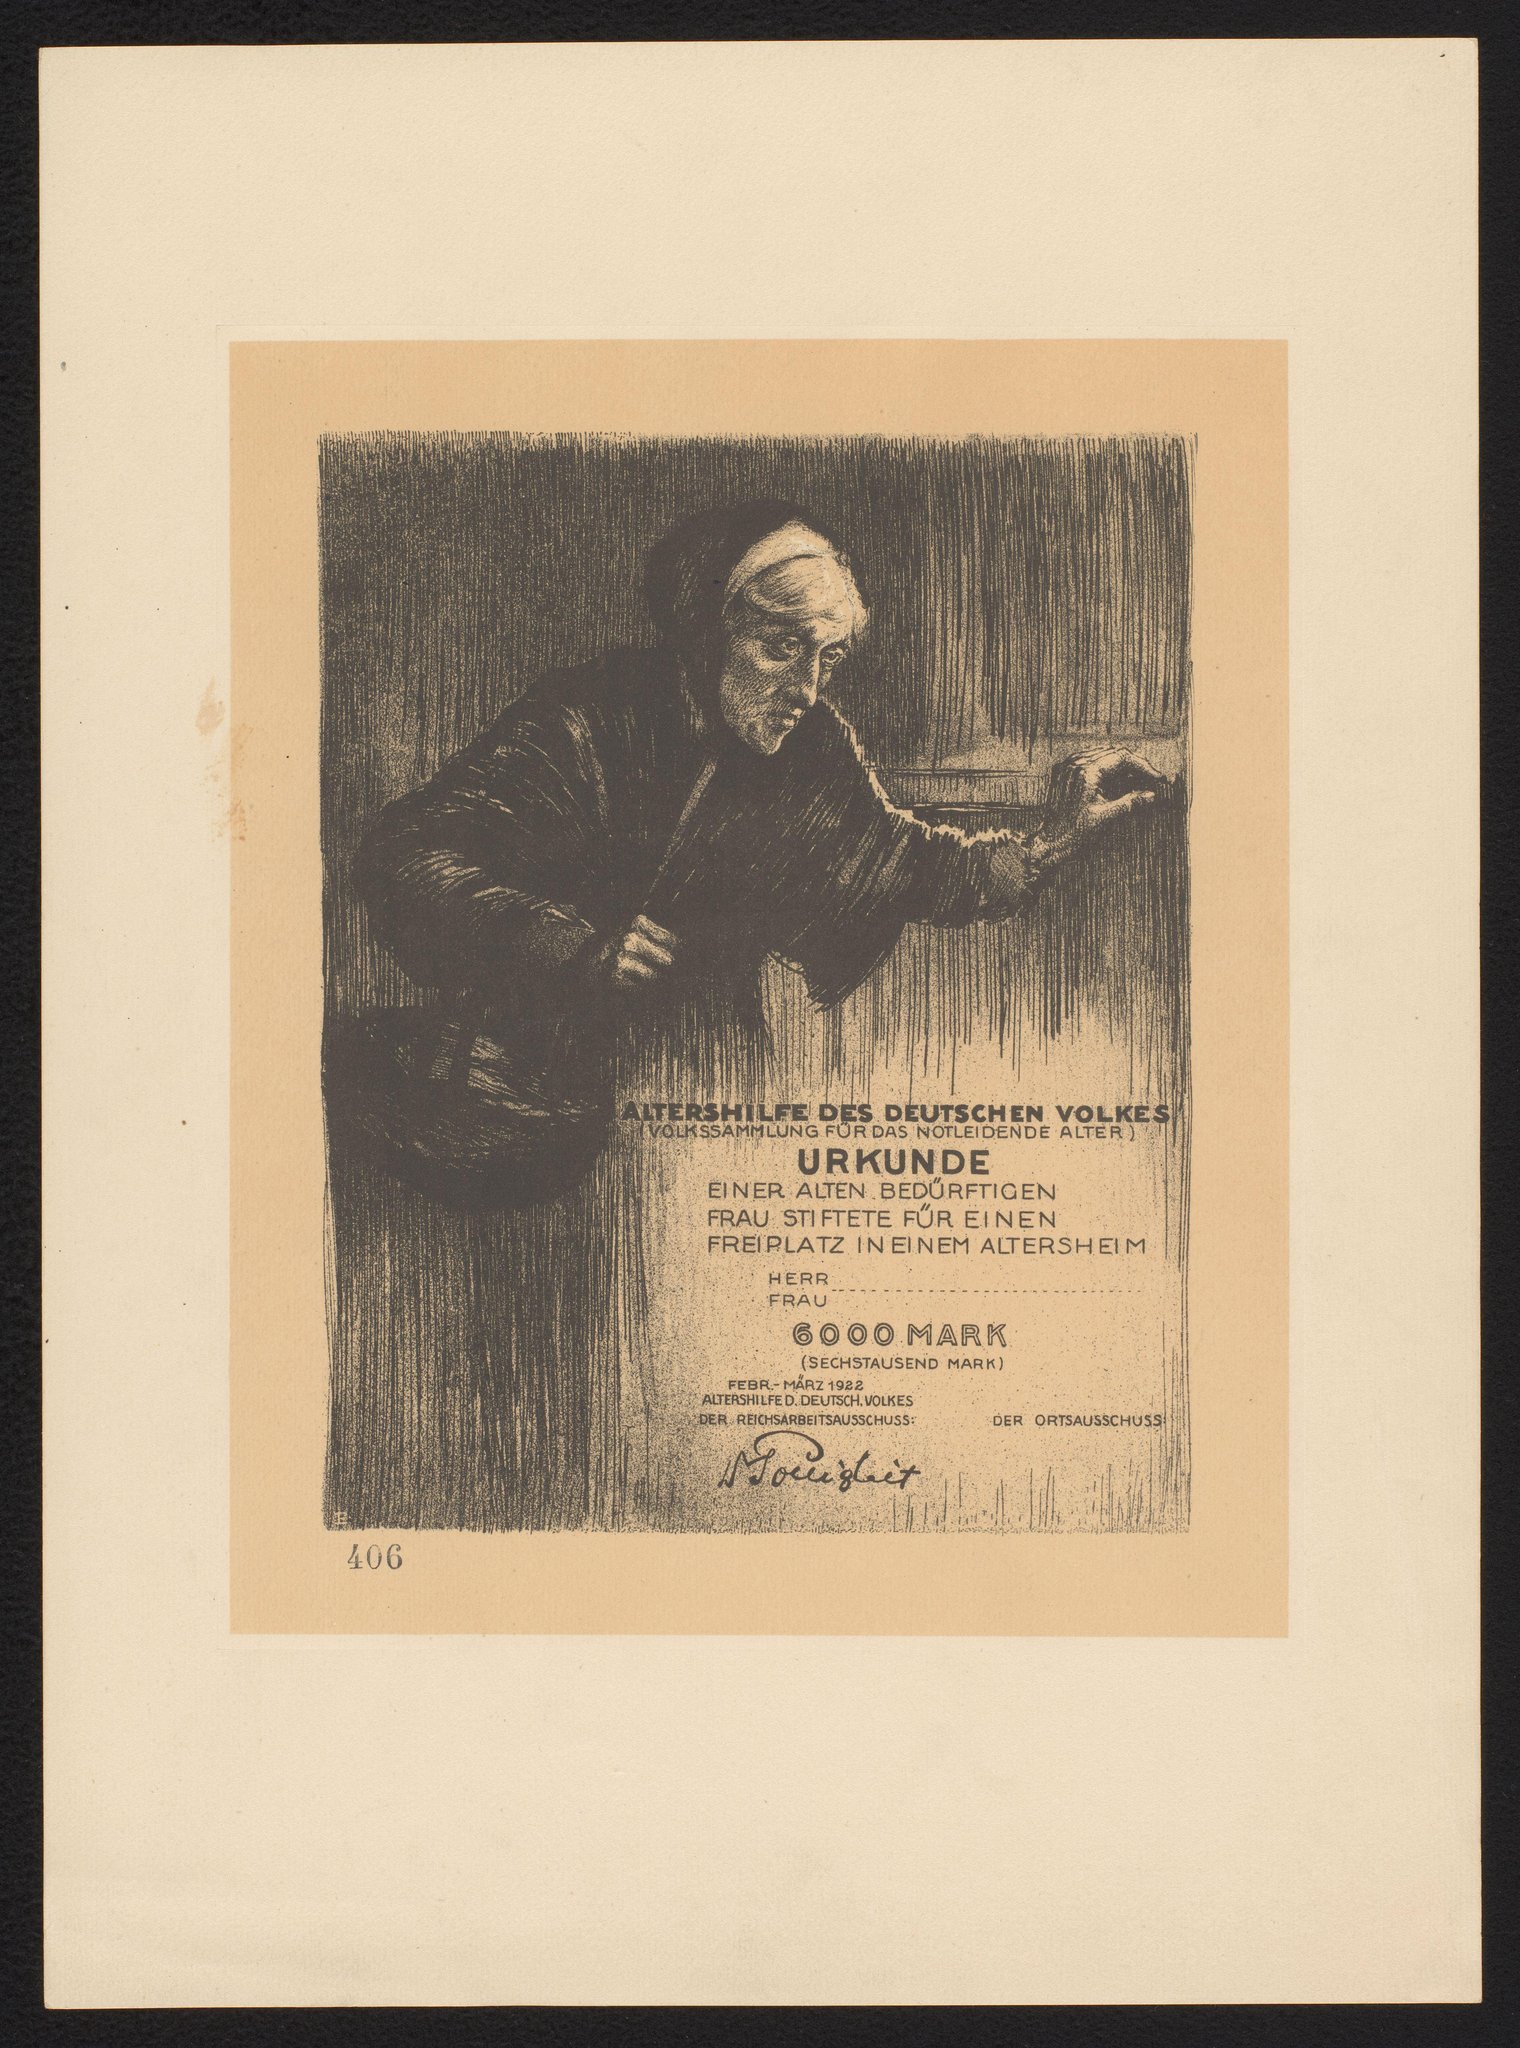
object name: print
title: Oningevuld oorkonde ten behoeve van Altershilfe des Deutsches Volkes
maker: Anonymous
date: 1902-1922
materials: paper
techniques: lithograph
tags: old woman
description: Een oude vrouw leunend op een richel. Daaronder de tekst van het oorkonde, voor iemand die 6000 Mark schonk ten behoeve van de ouderenhulp in Duitsland in 1922. Volgens de tekst ('einer alten Bedürftigen Frau stiftete für einen Freiplatz in einem Altersheim') was dit voldoende om een oude vrouw in een bejaardenhuis te huisvesten. Deze inzamelingsactie voor noodlijdende ouderen werd in februari - maart 1922 georganiseerd door de Reichsarbeitsausschuss.